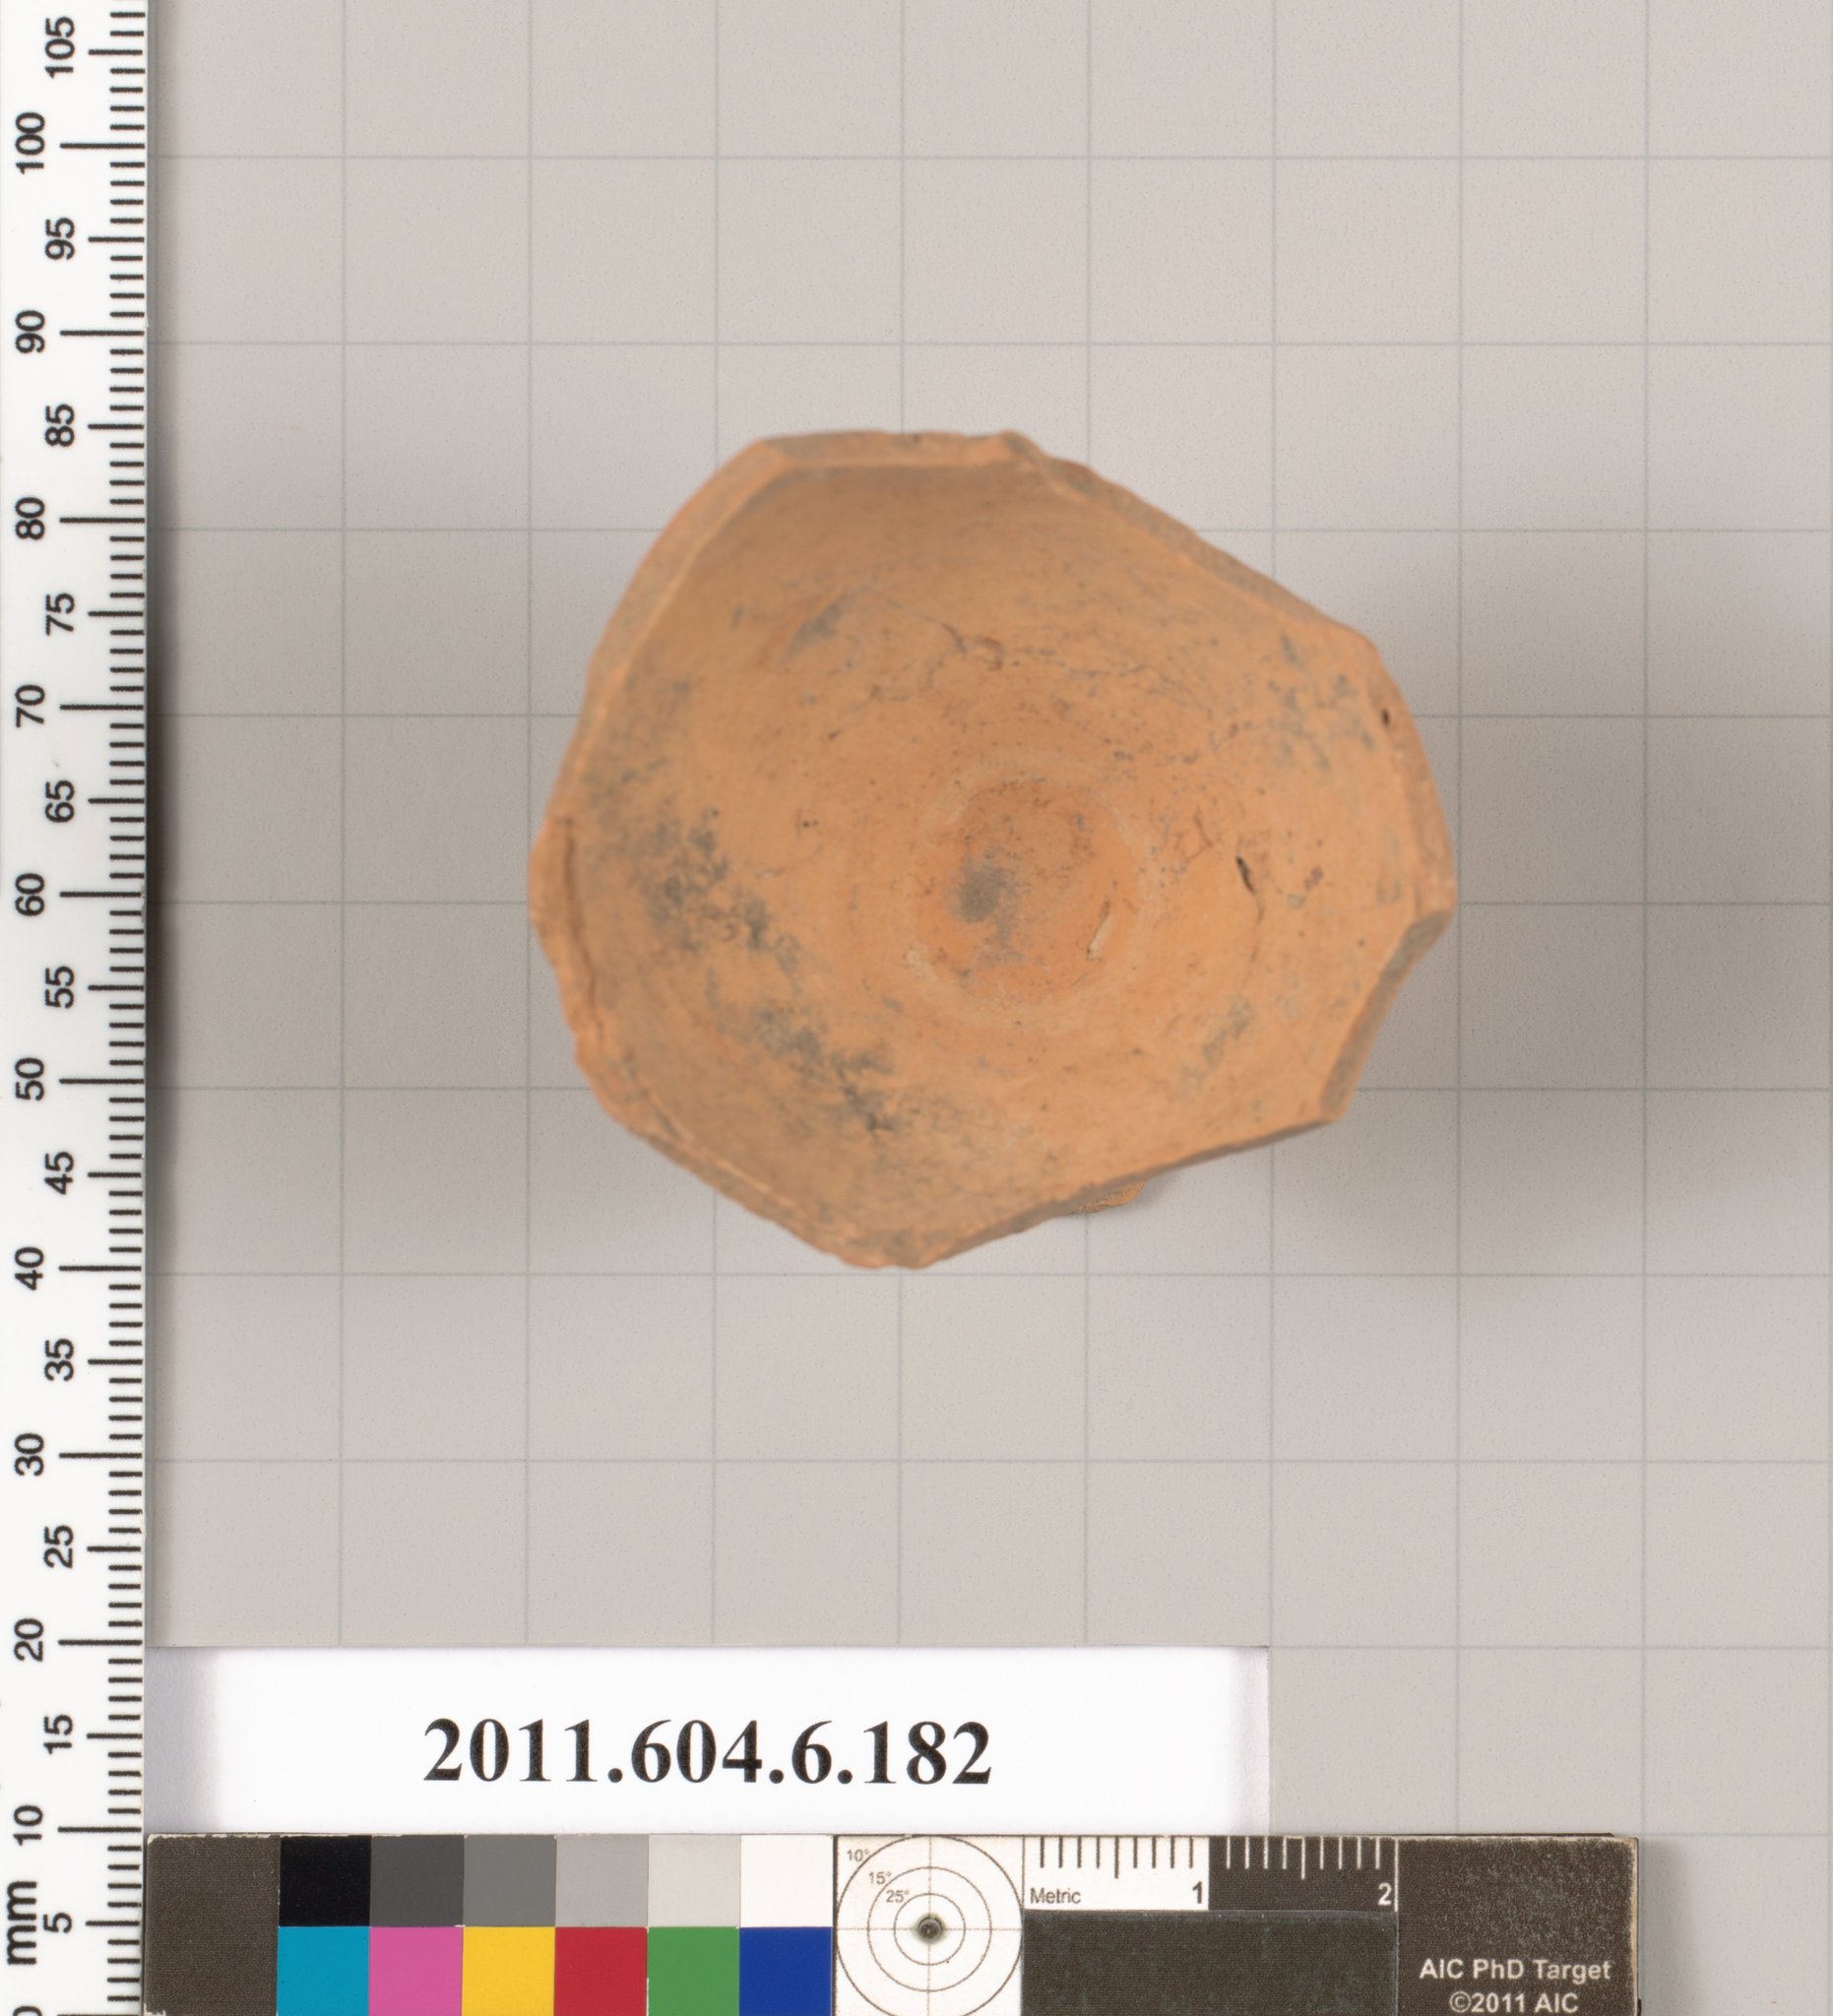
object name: lekythos fragment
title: Terracotta fragment of a lekythos (oil flask)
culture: greek, attic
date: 500-401 BCE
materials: terracotta